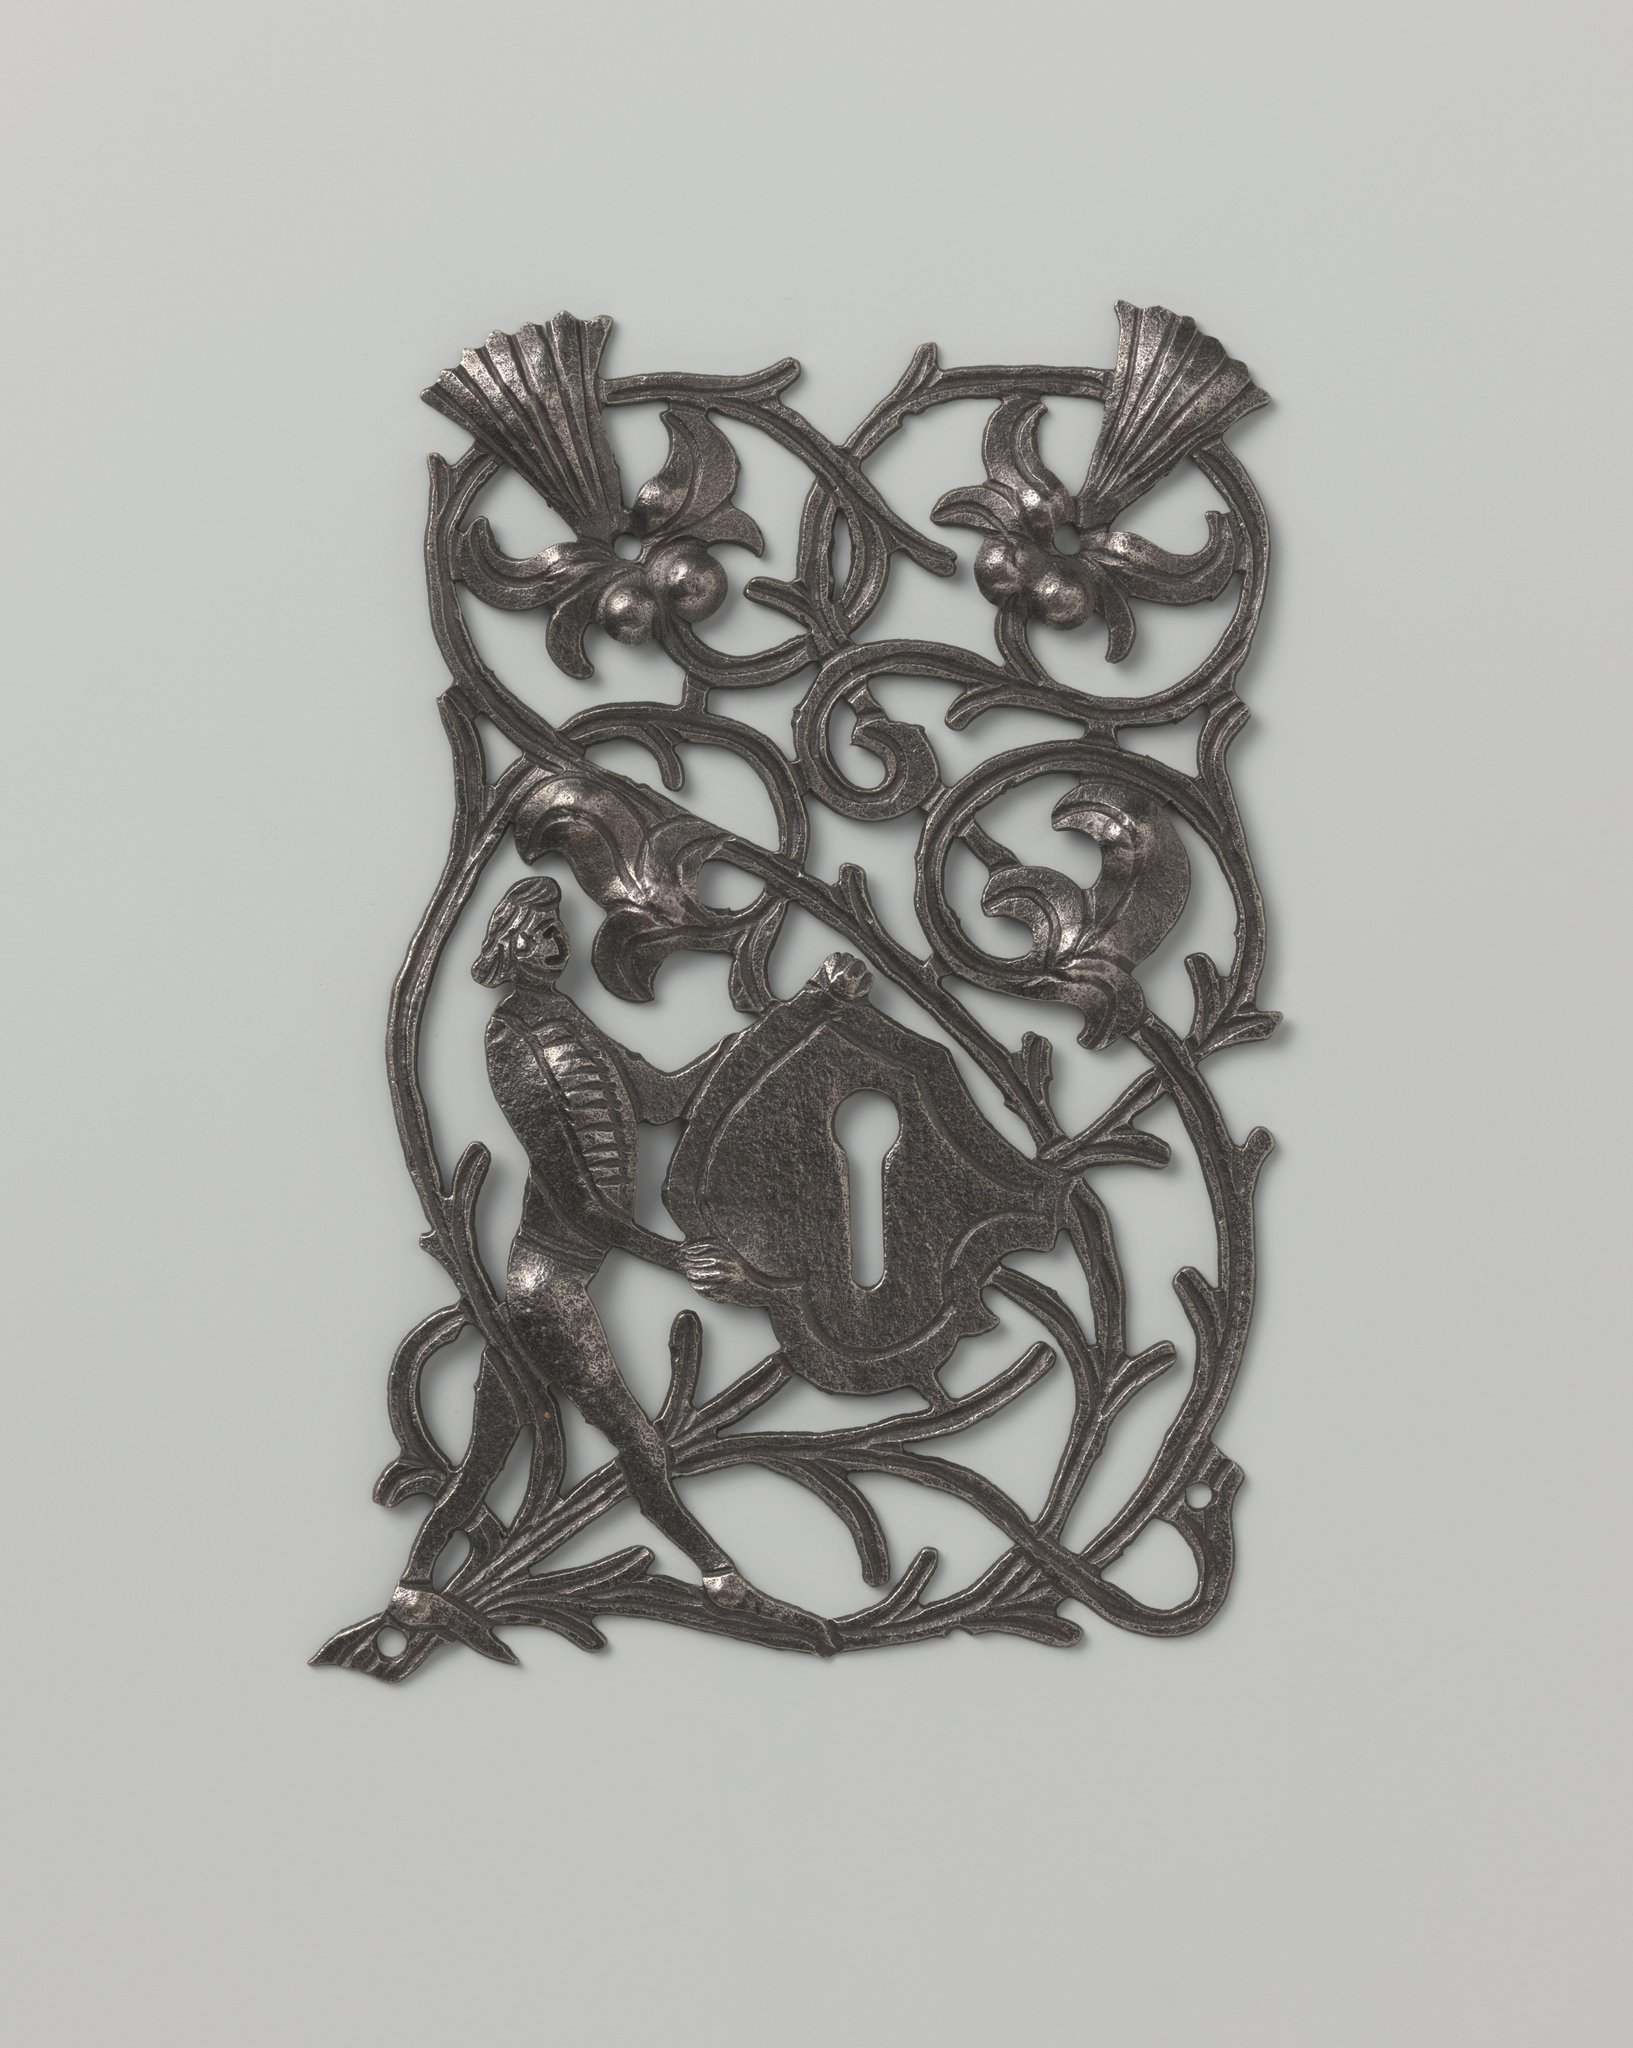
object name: slotplaat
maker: Anonymous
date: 1500-1525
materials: iron, tin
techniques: metalworking, engraving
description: Opengewerkte slotplaat van vertind ijzer. In basisvorm rechthoekig, versierd met vervlochten blad- en rankmotieven. Links onderaan een man met een soort wapenschild voor zich, waarin het sleutelgat is aangebracht. In de twee bovenhoeken vruchten aan een gecanneleerd blad.